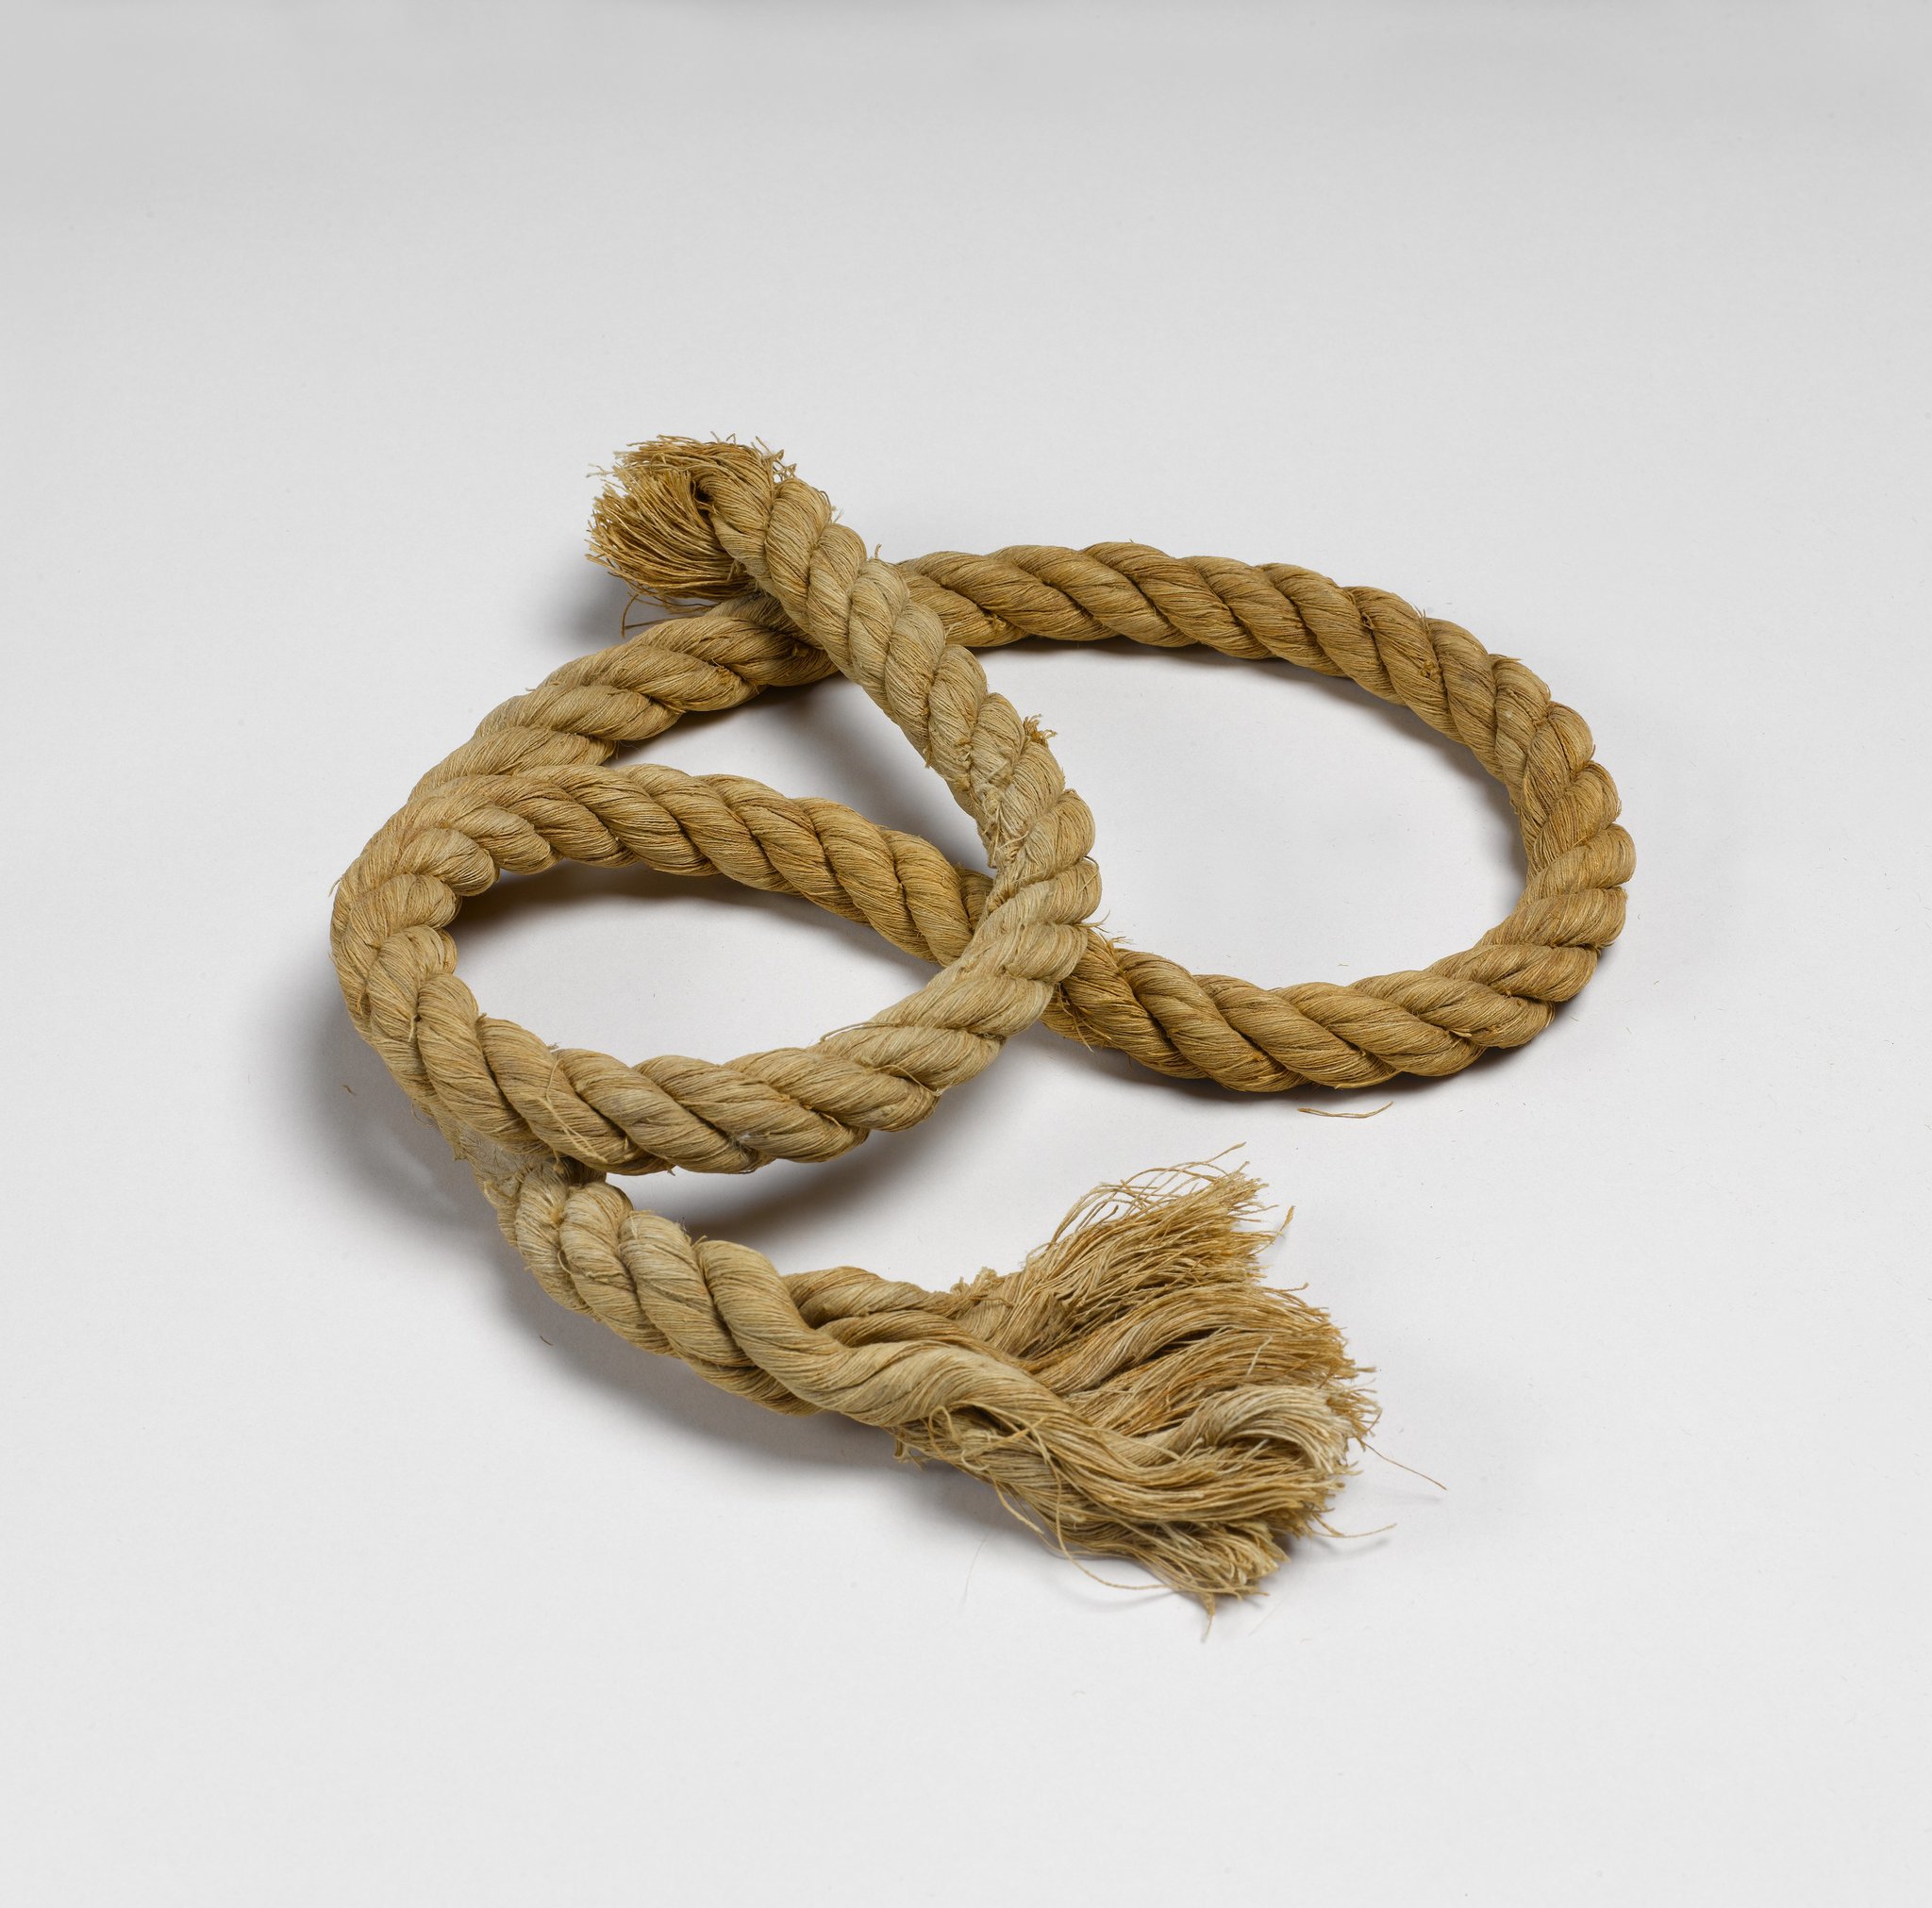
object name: rope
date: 2030-1640 BCE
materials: fiber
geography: egypt